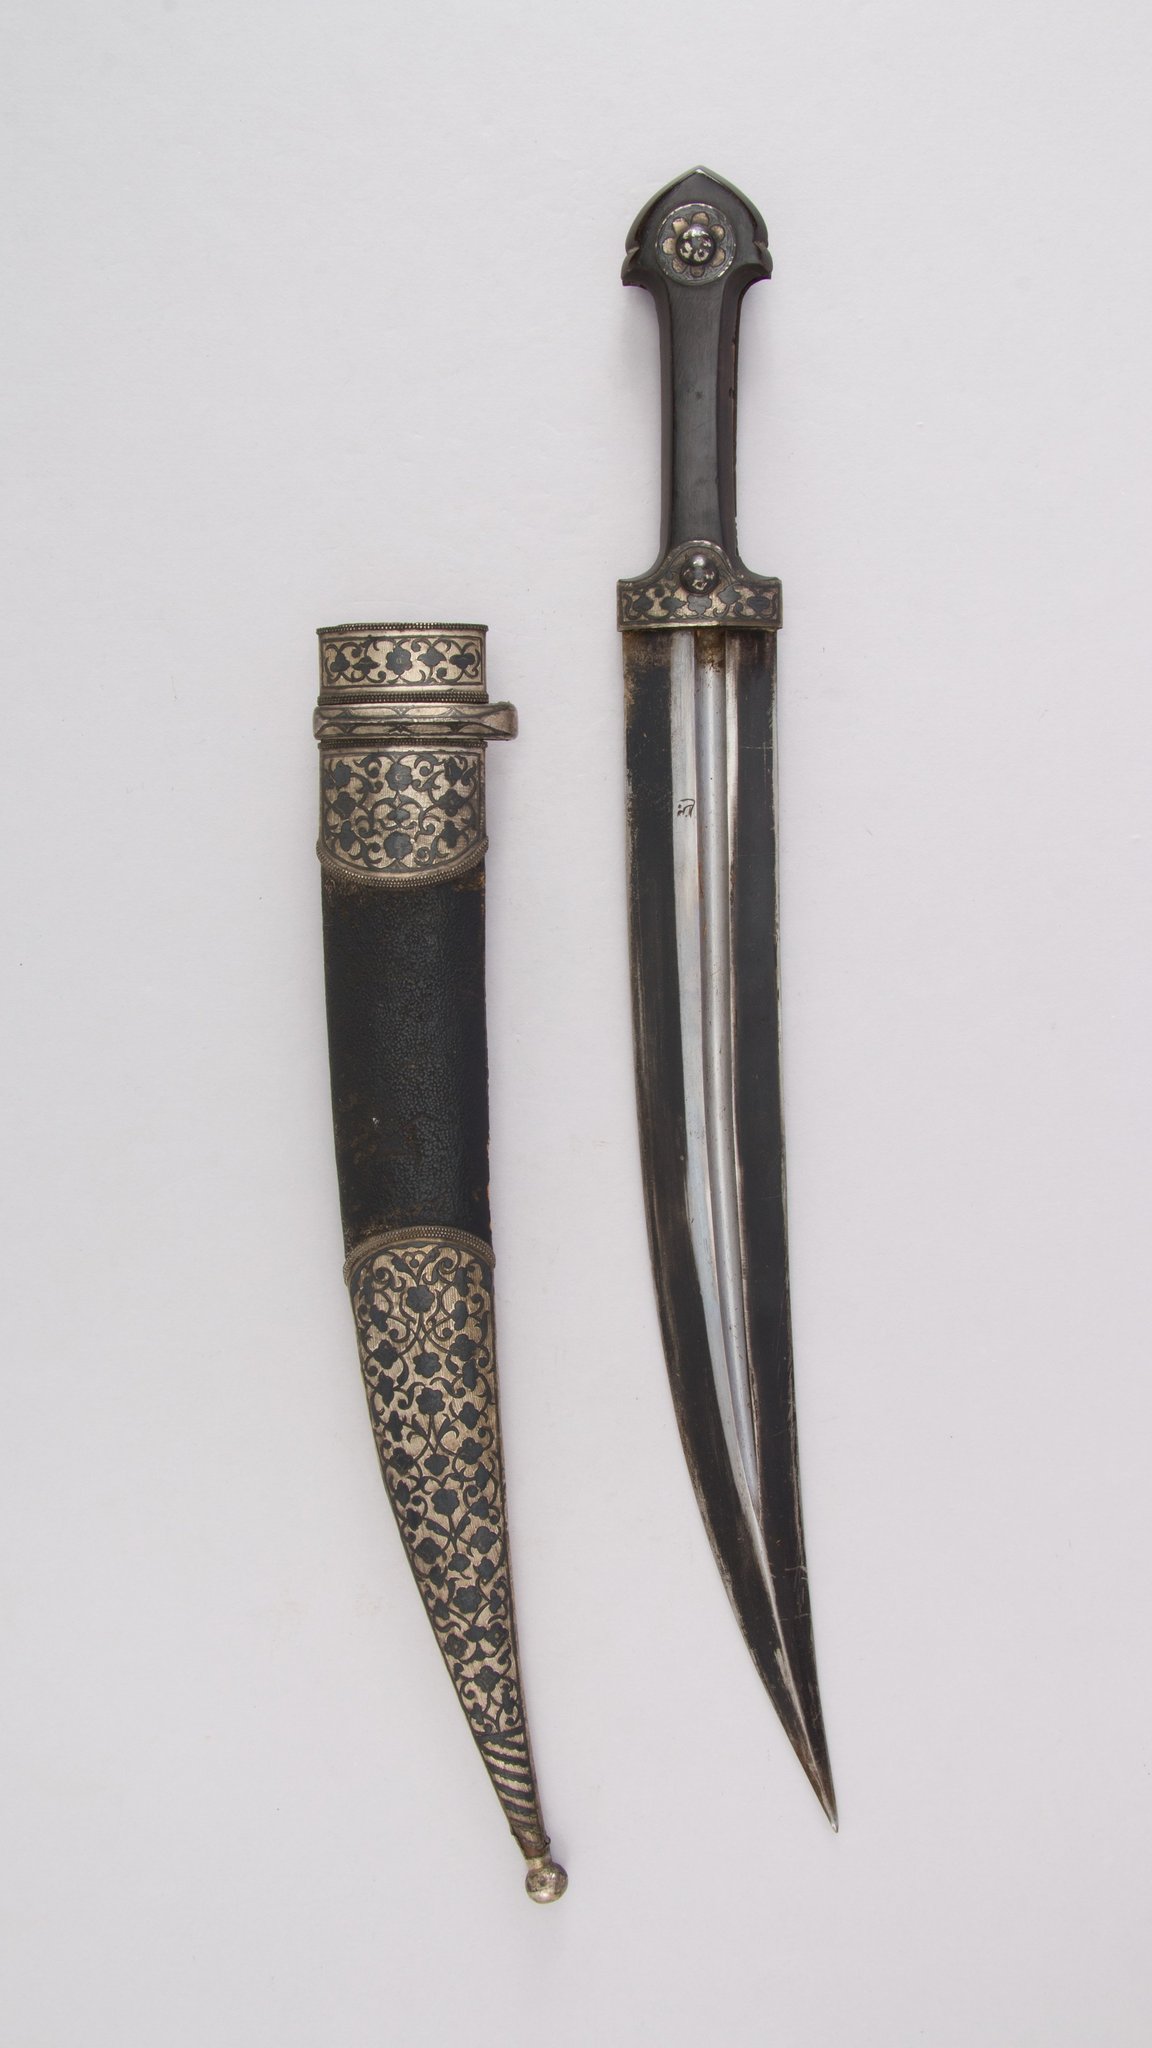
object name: dagger with sheath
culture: caucasian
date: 1801-1900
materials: leather, silver, steel, wood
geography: caucasus